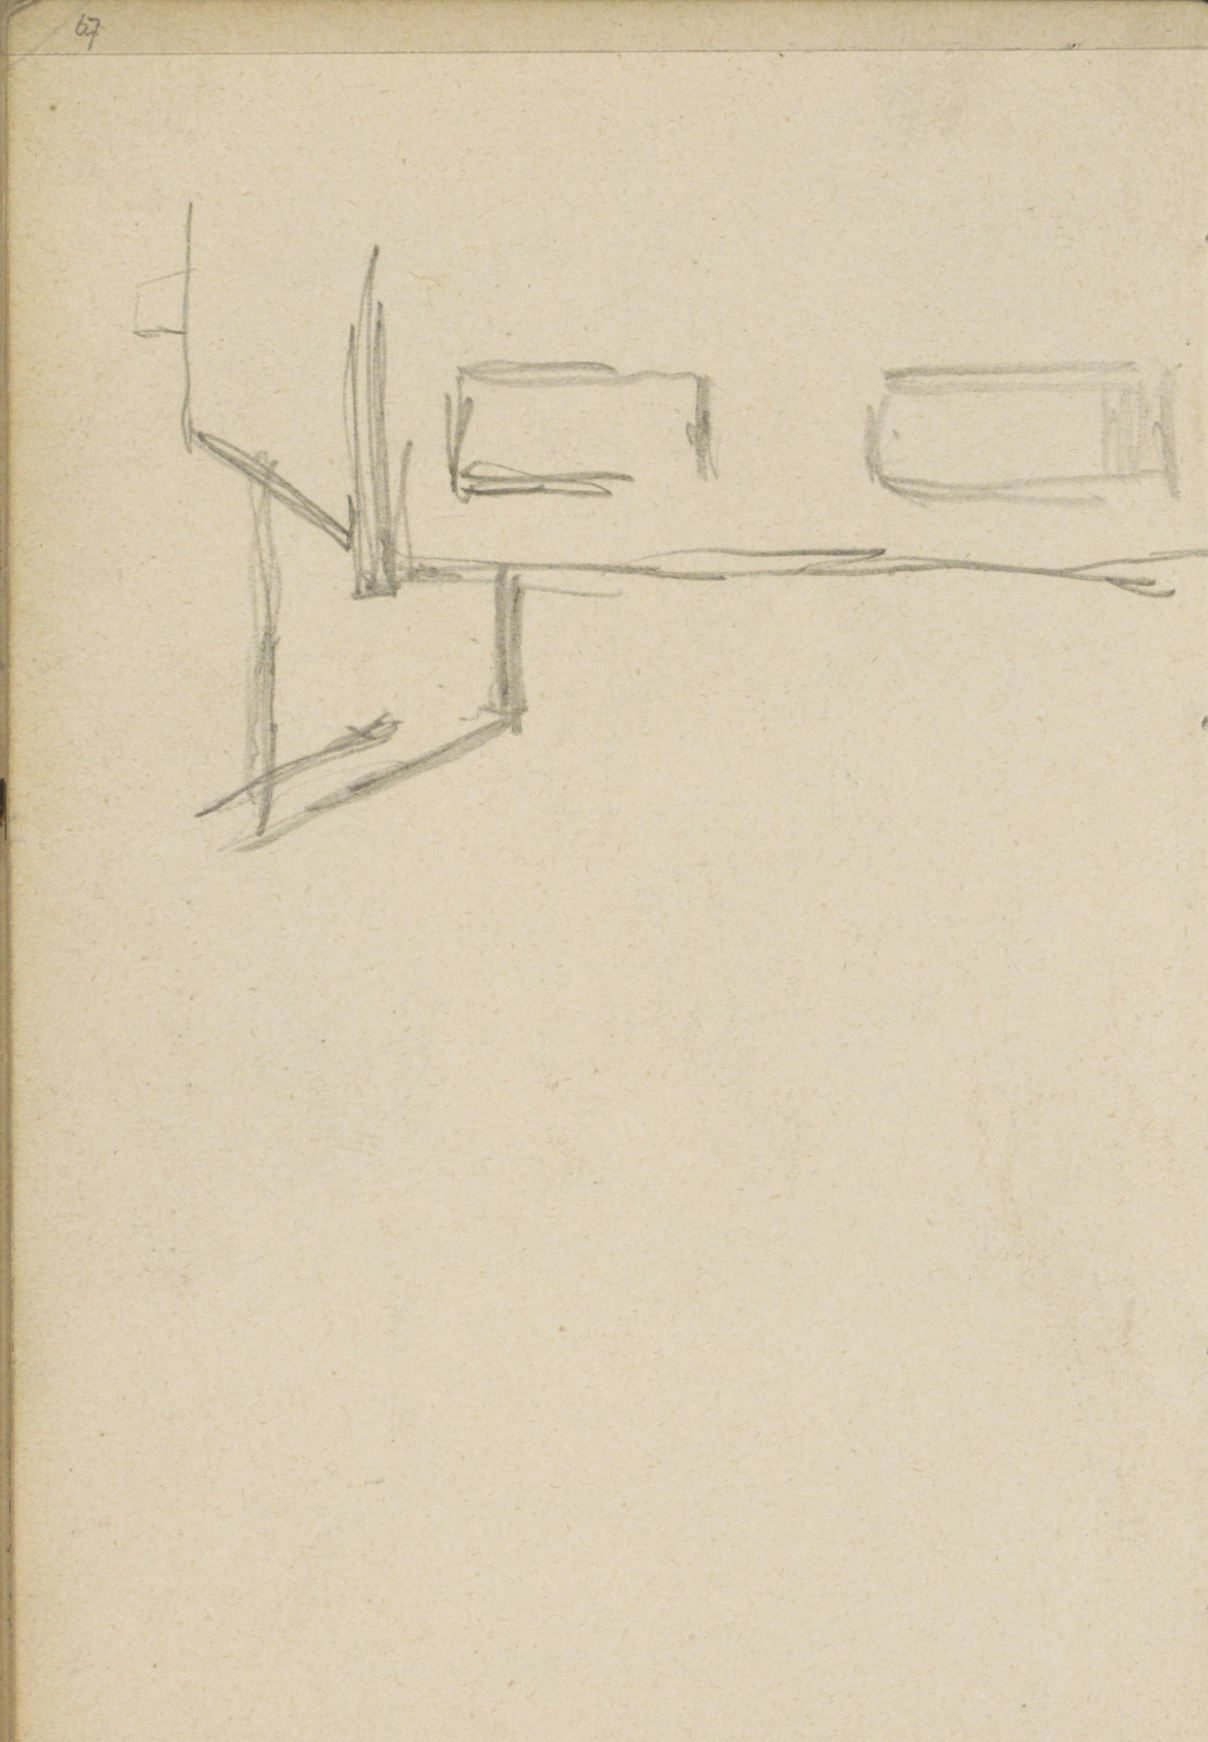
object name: sketchbook leaf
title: Gevel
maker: george hendrik breitner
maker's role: draughtsman, painter, print maker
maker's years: 1857-1923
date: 1903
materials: paper, pencil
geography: amsterdam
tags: façade (of house or building)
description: Gevel. Pagina 67 uit een schetsboek met 46 bladen vervaardigd te Amsterdam en Haarlem.